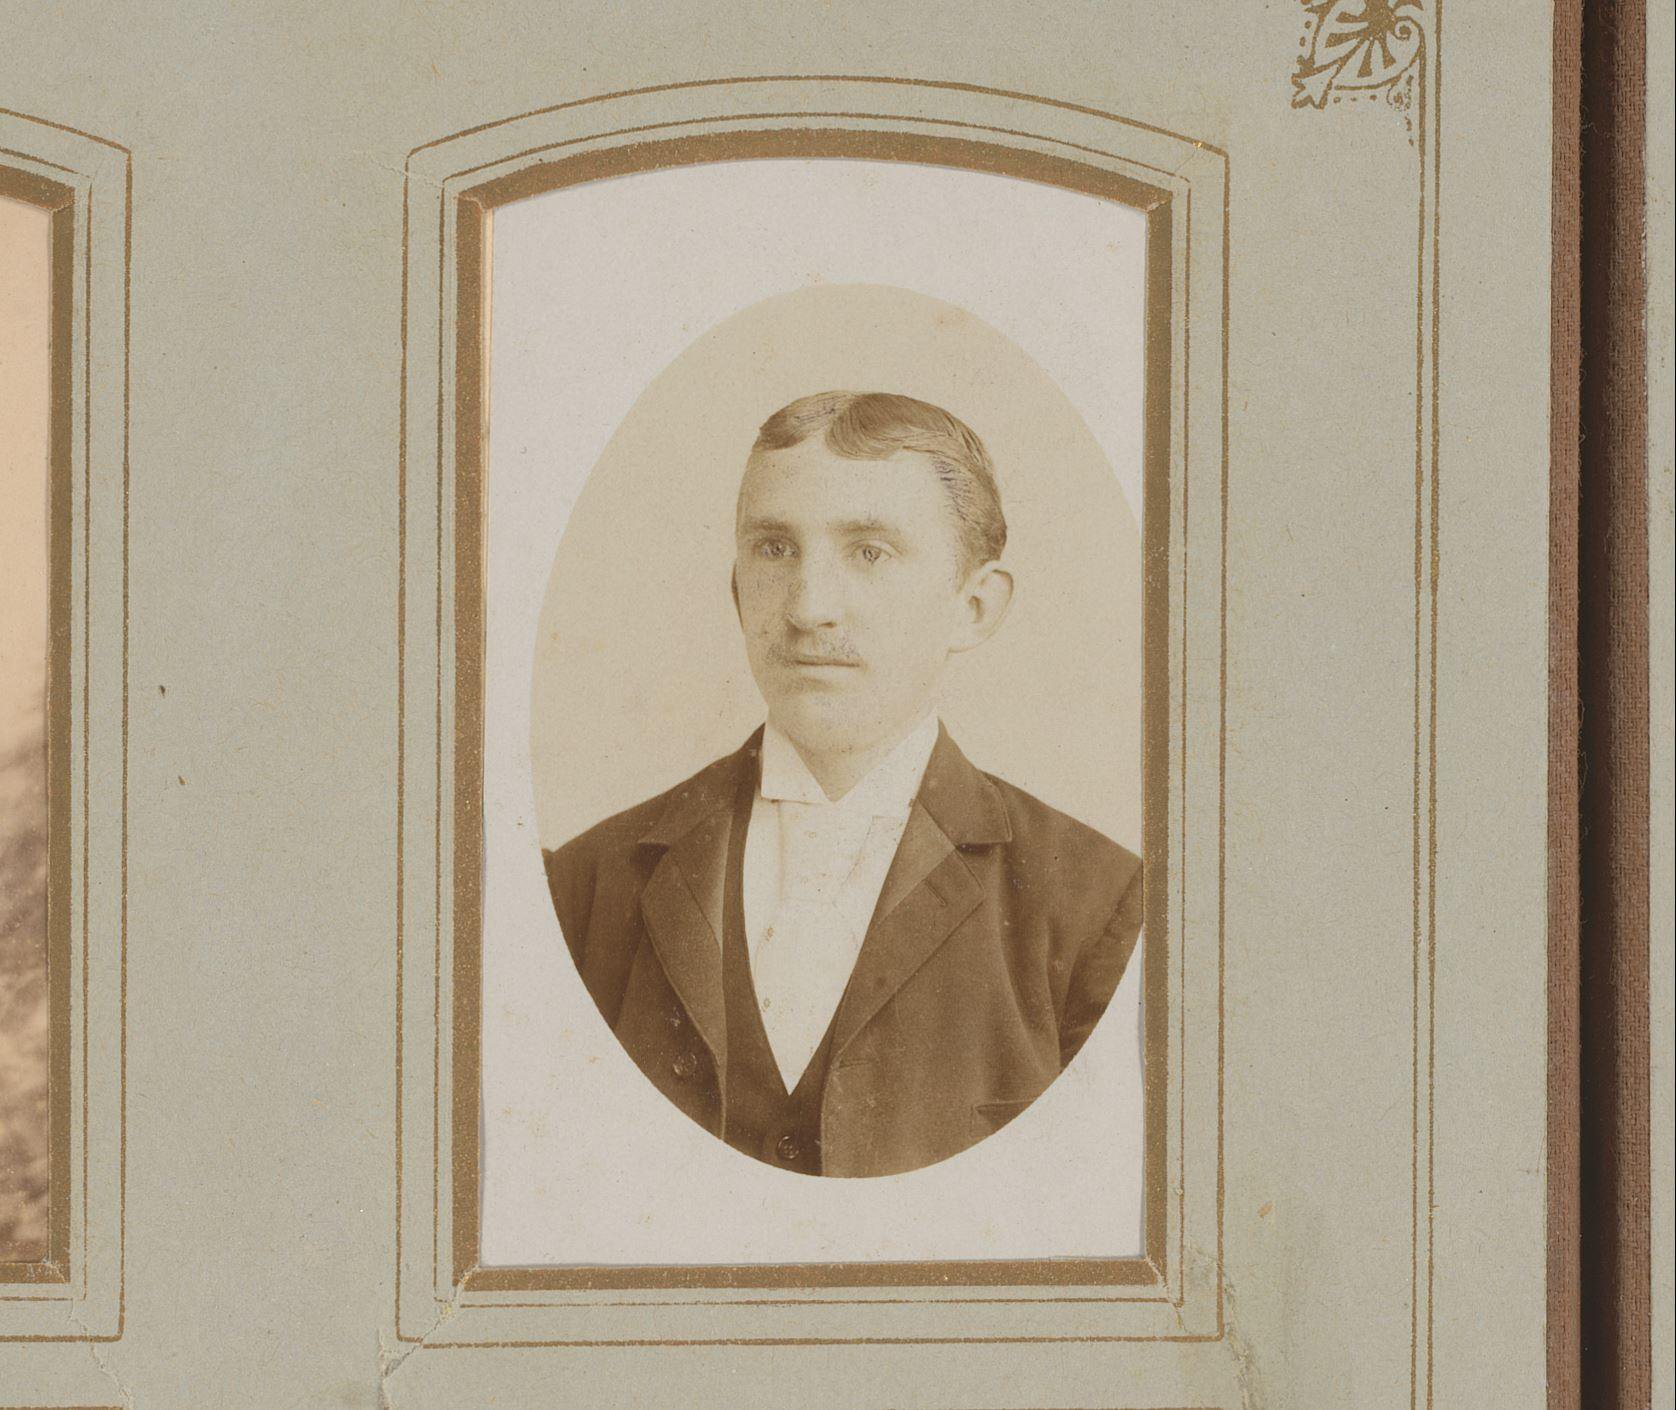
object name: photograph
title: Portret van een man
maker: max cosman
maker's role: fotograaf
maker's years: 1852-1894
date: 1881-1903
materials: cardboard, photographic support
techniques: collodion silver print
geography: amsterdam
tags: historical persons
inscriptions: inscription: ‘Max Cosman/ Hofphotograaf/ Amsterdam/ Koningsplein 1/ Hoek Singel./ Galerij 48./ Filiaal: Bad Kleef./ Specialiteit/ in/ Vergrootingen. Kooldruk Onveranderlijk./ De plaat blijft voor nabestelling bewaard.’